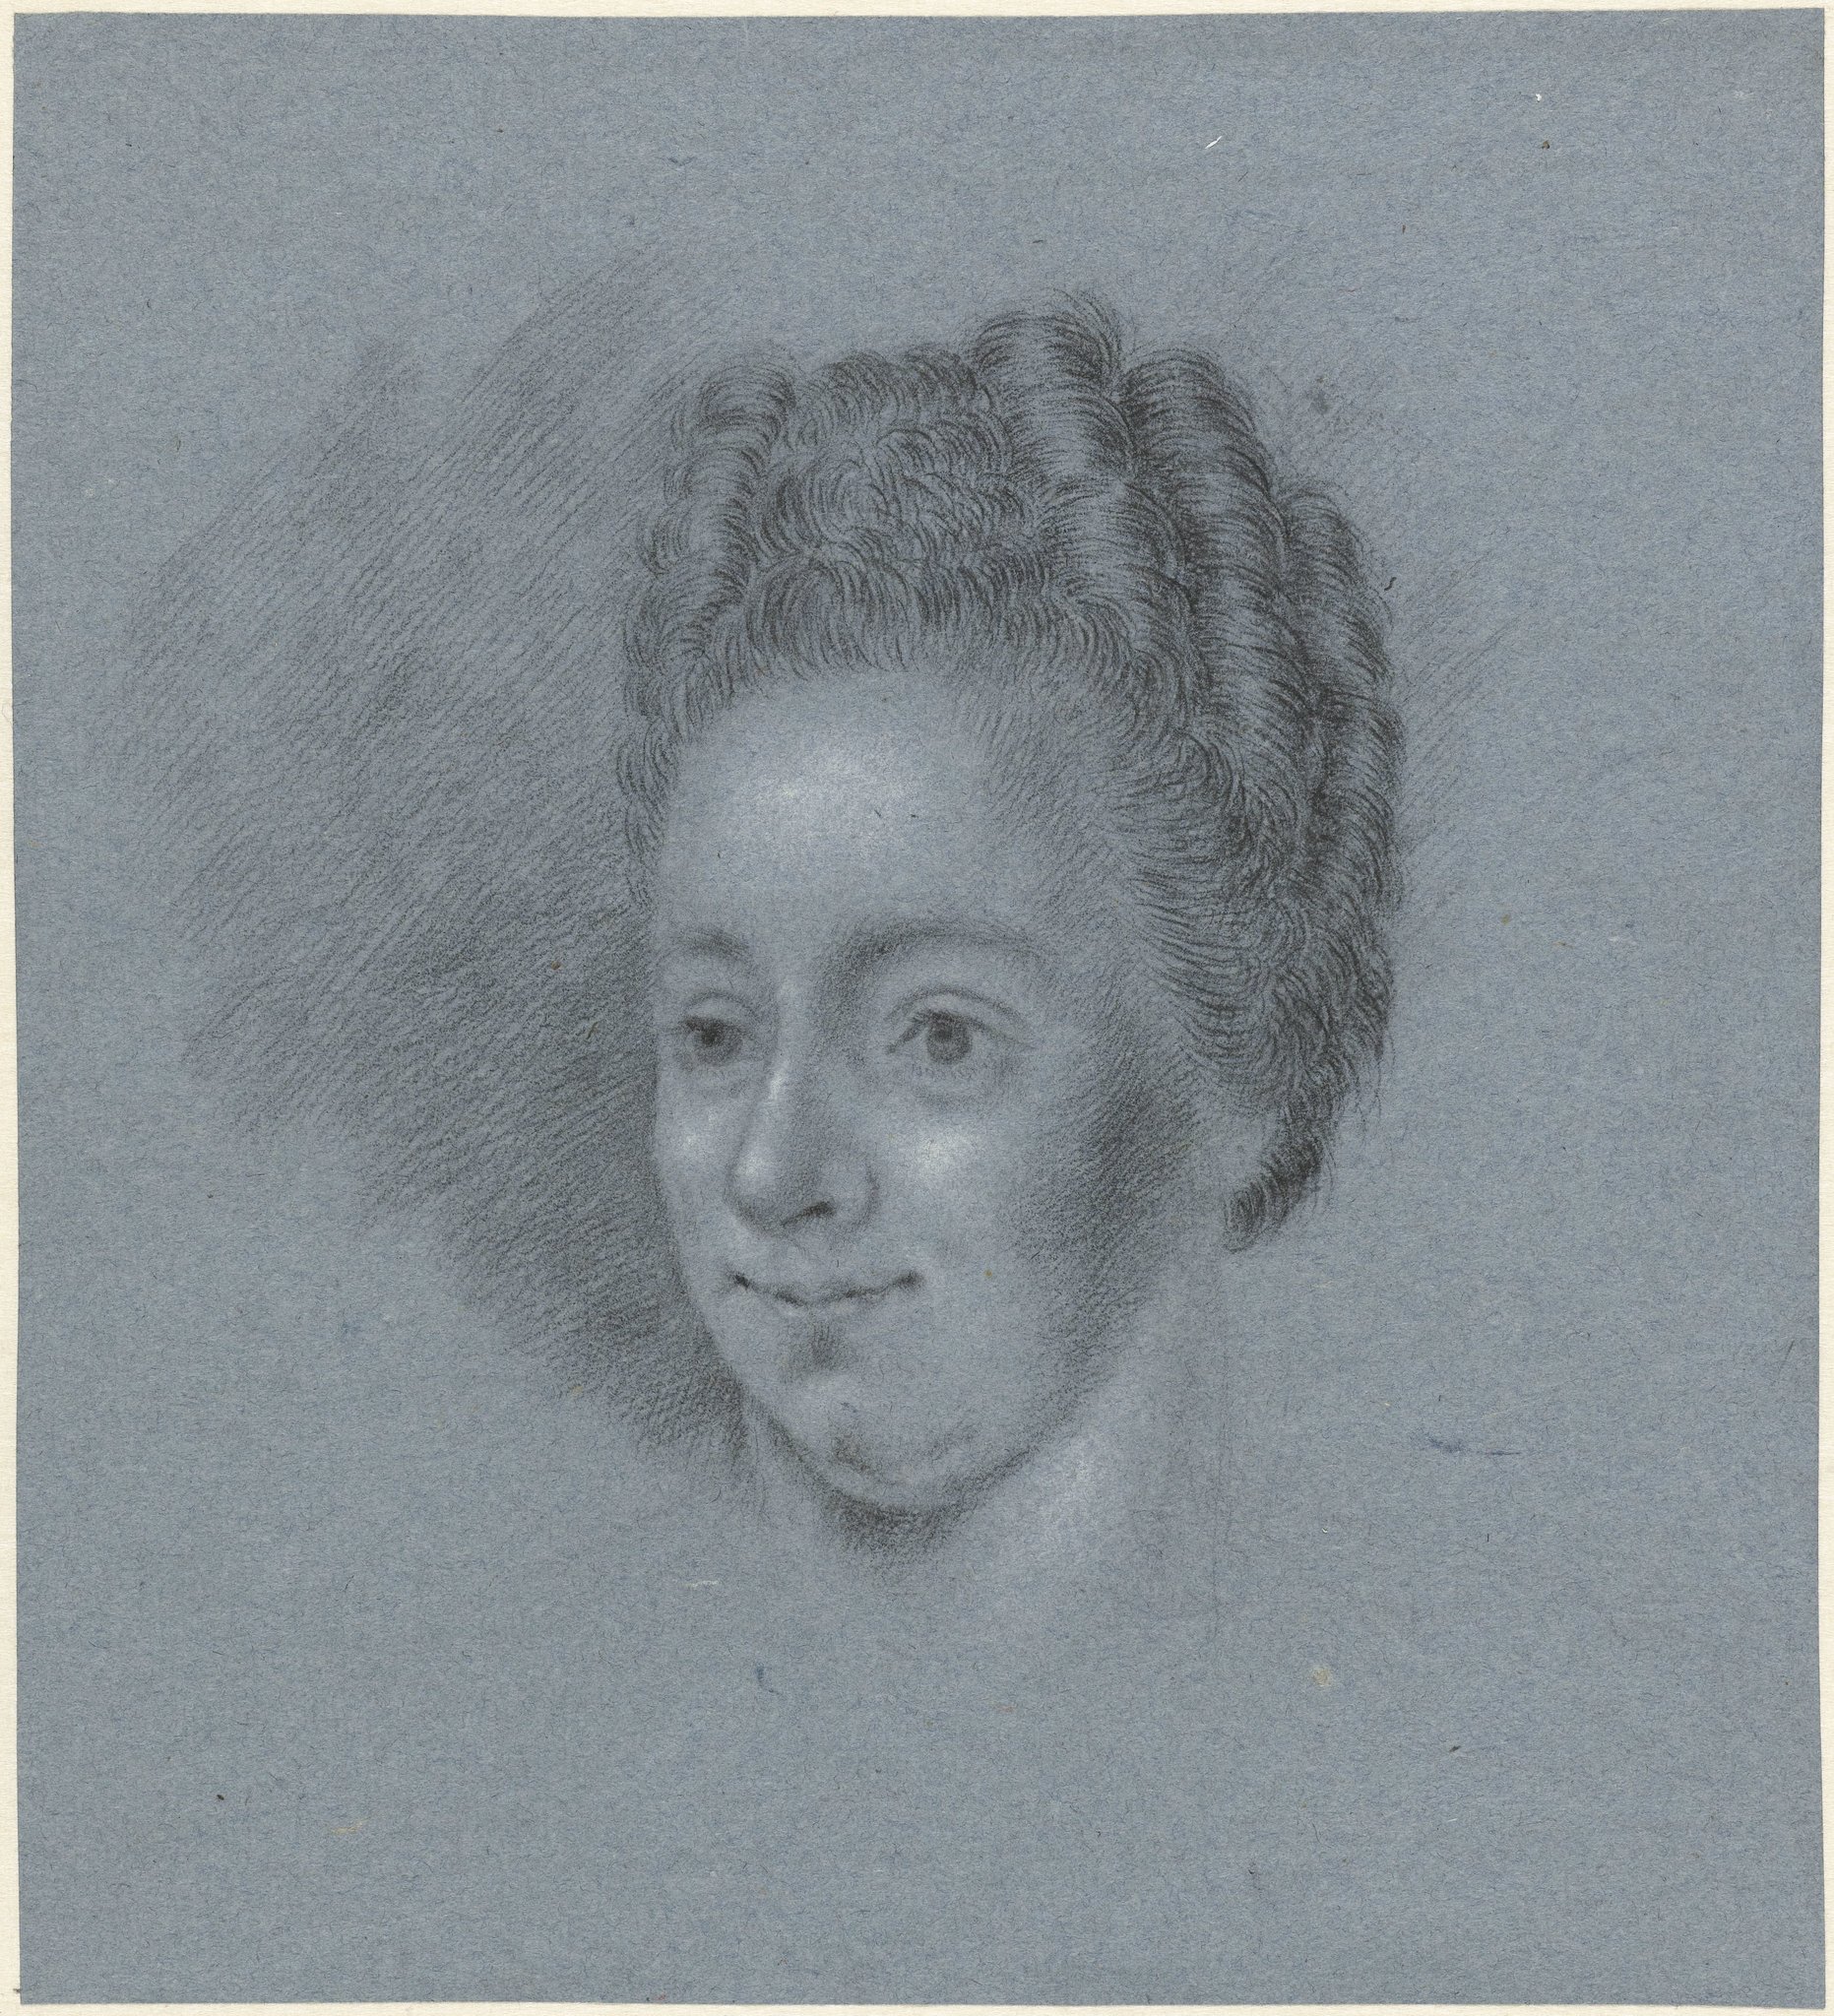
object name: drawing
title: Portret van een vrouw, naar links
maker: mattheus verheyden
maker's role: draughtsman, painter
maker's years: 1700-1777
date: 1710-1777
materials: chalk, paper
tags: anonymous historical person portrayed